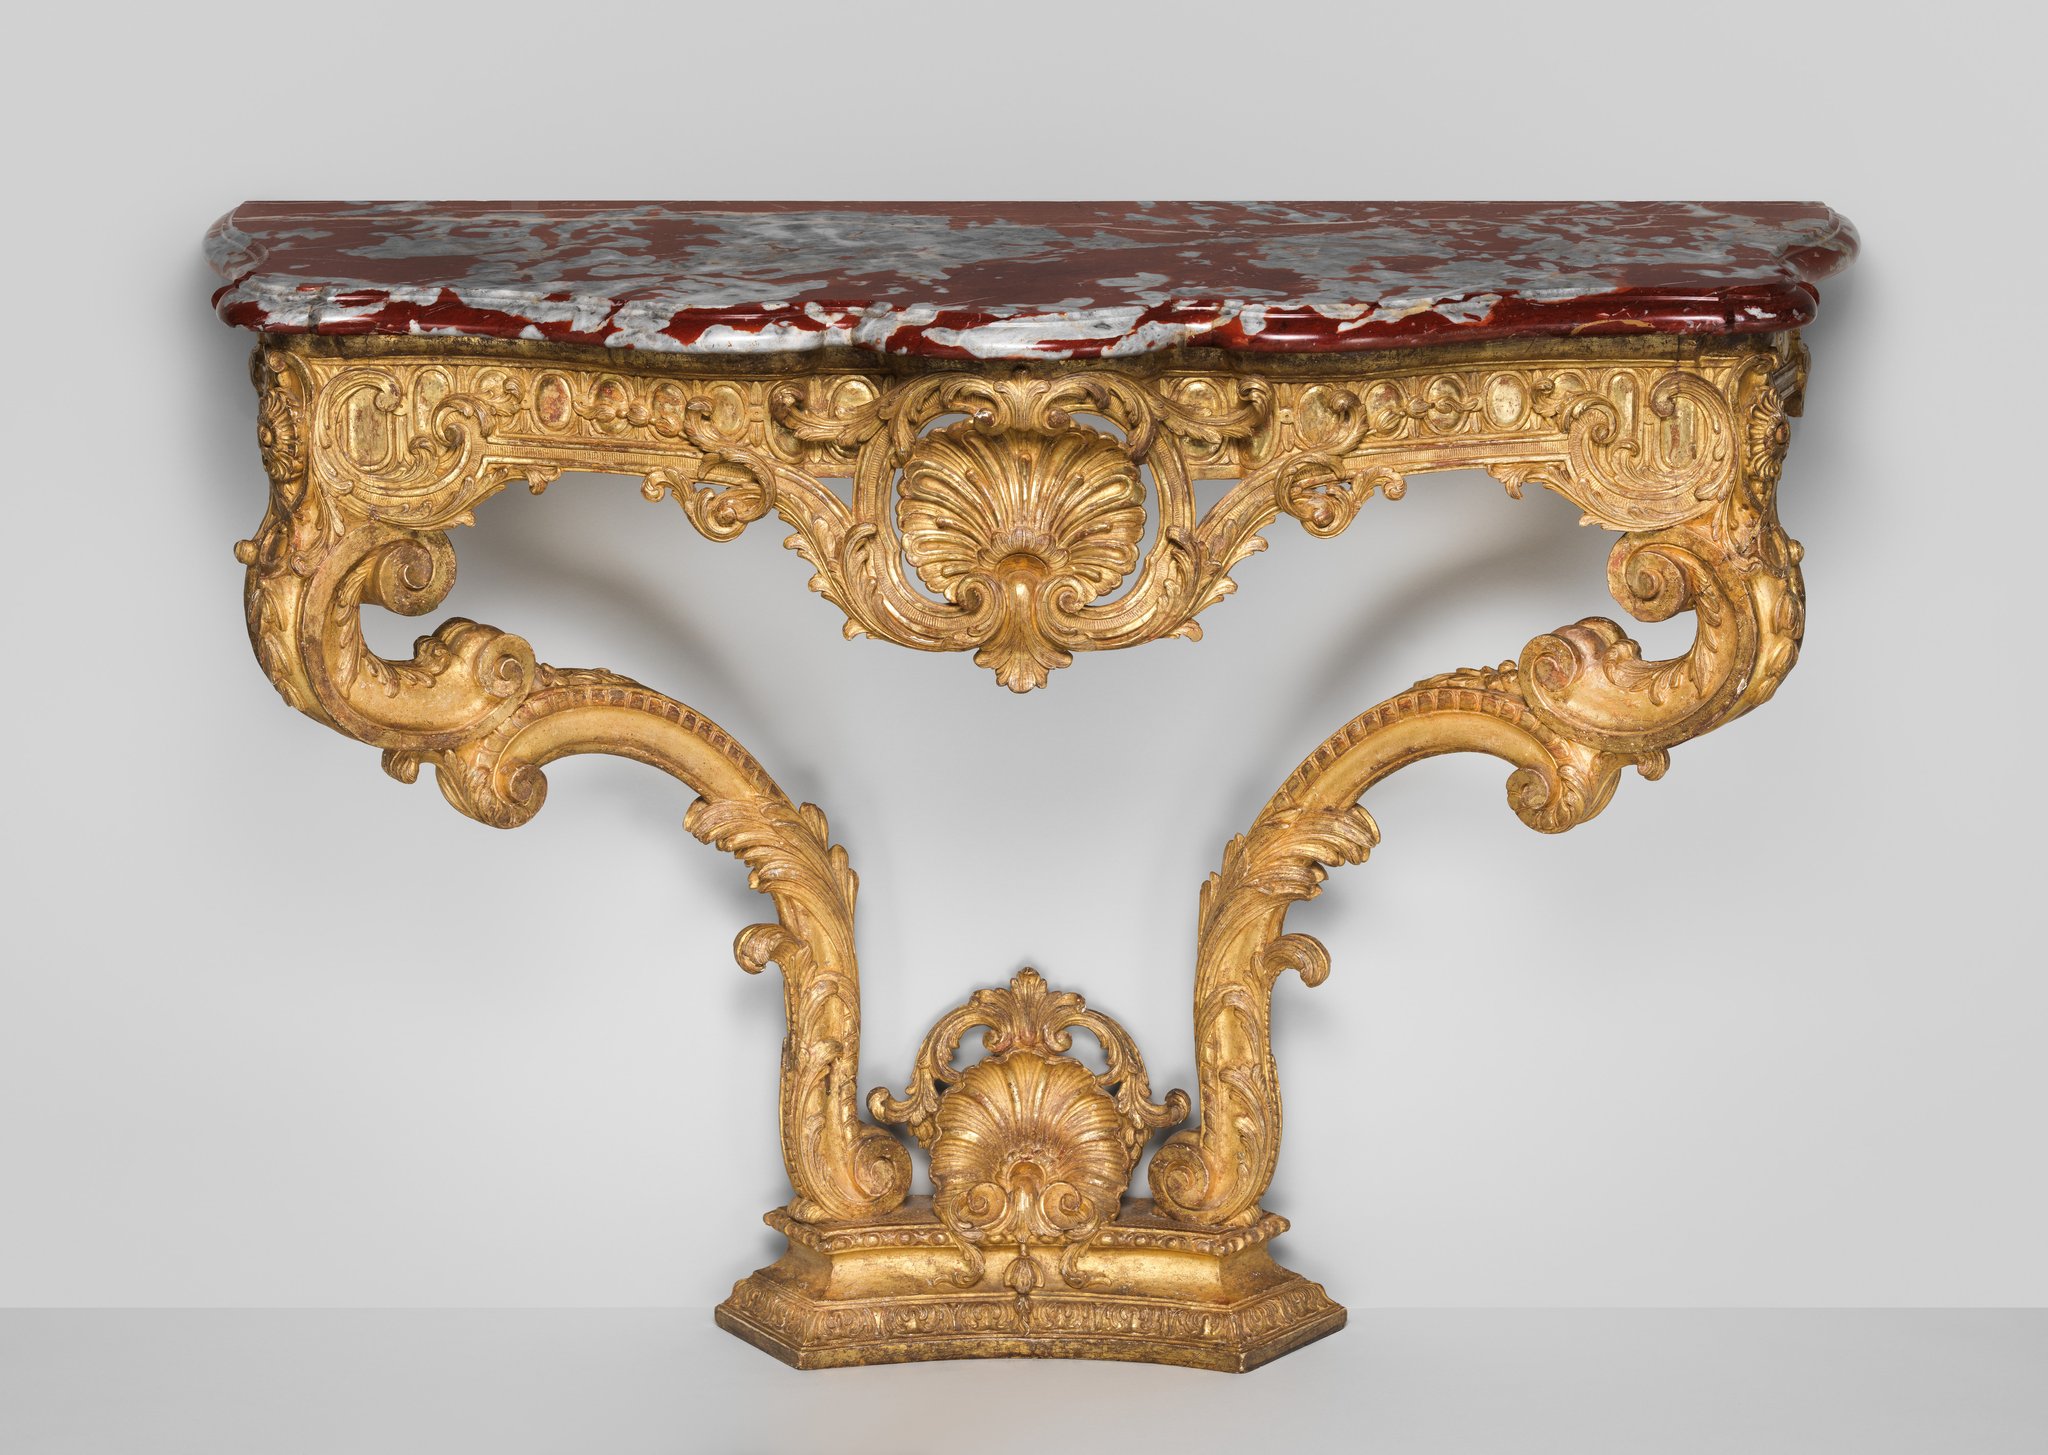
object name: console table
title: Console Table (one of a pair)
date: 1725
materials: gilt, marble, wood